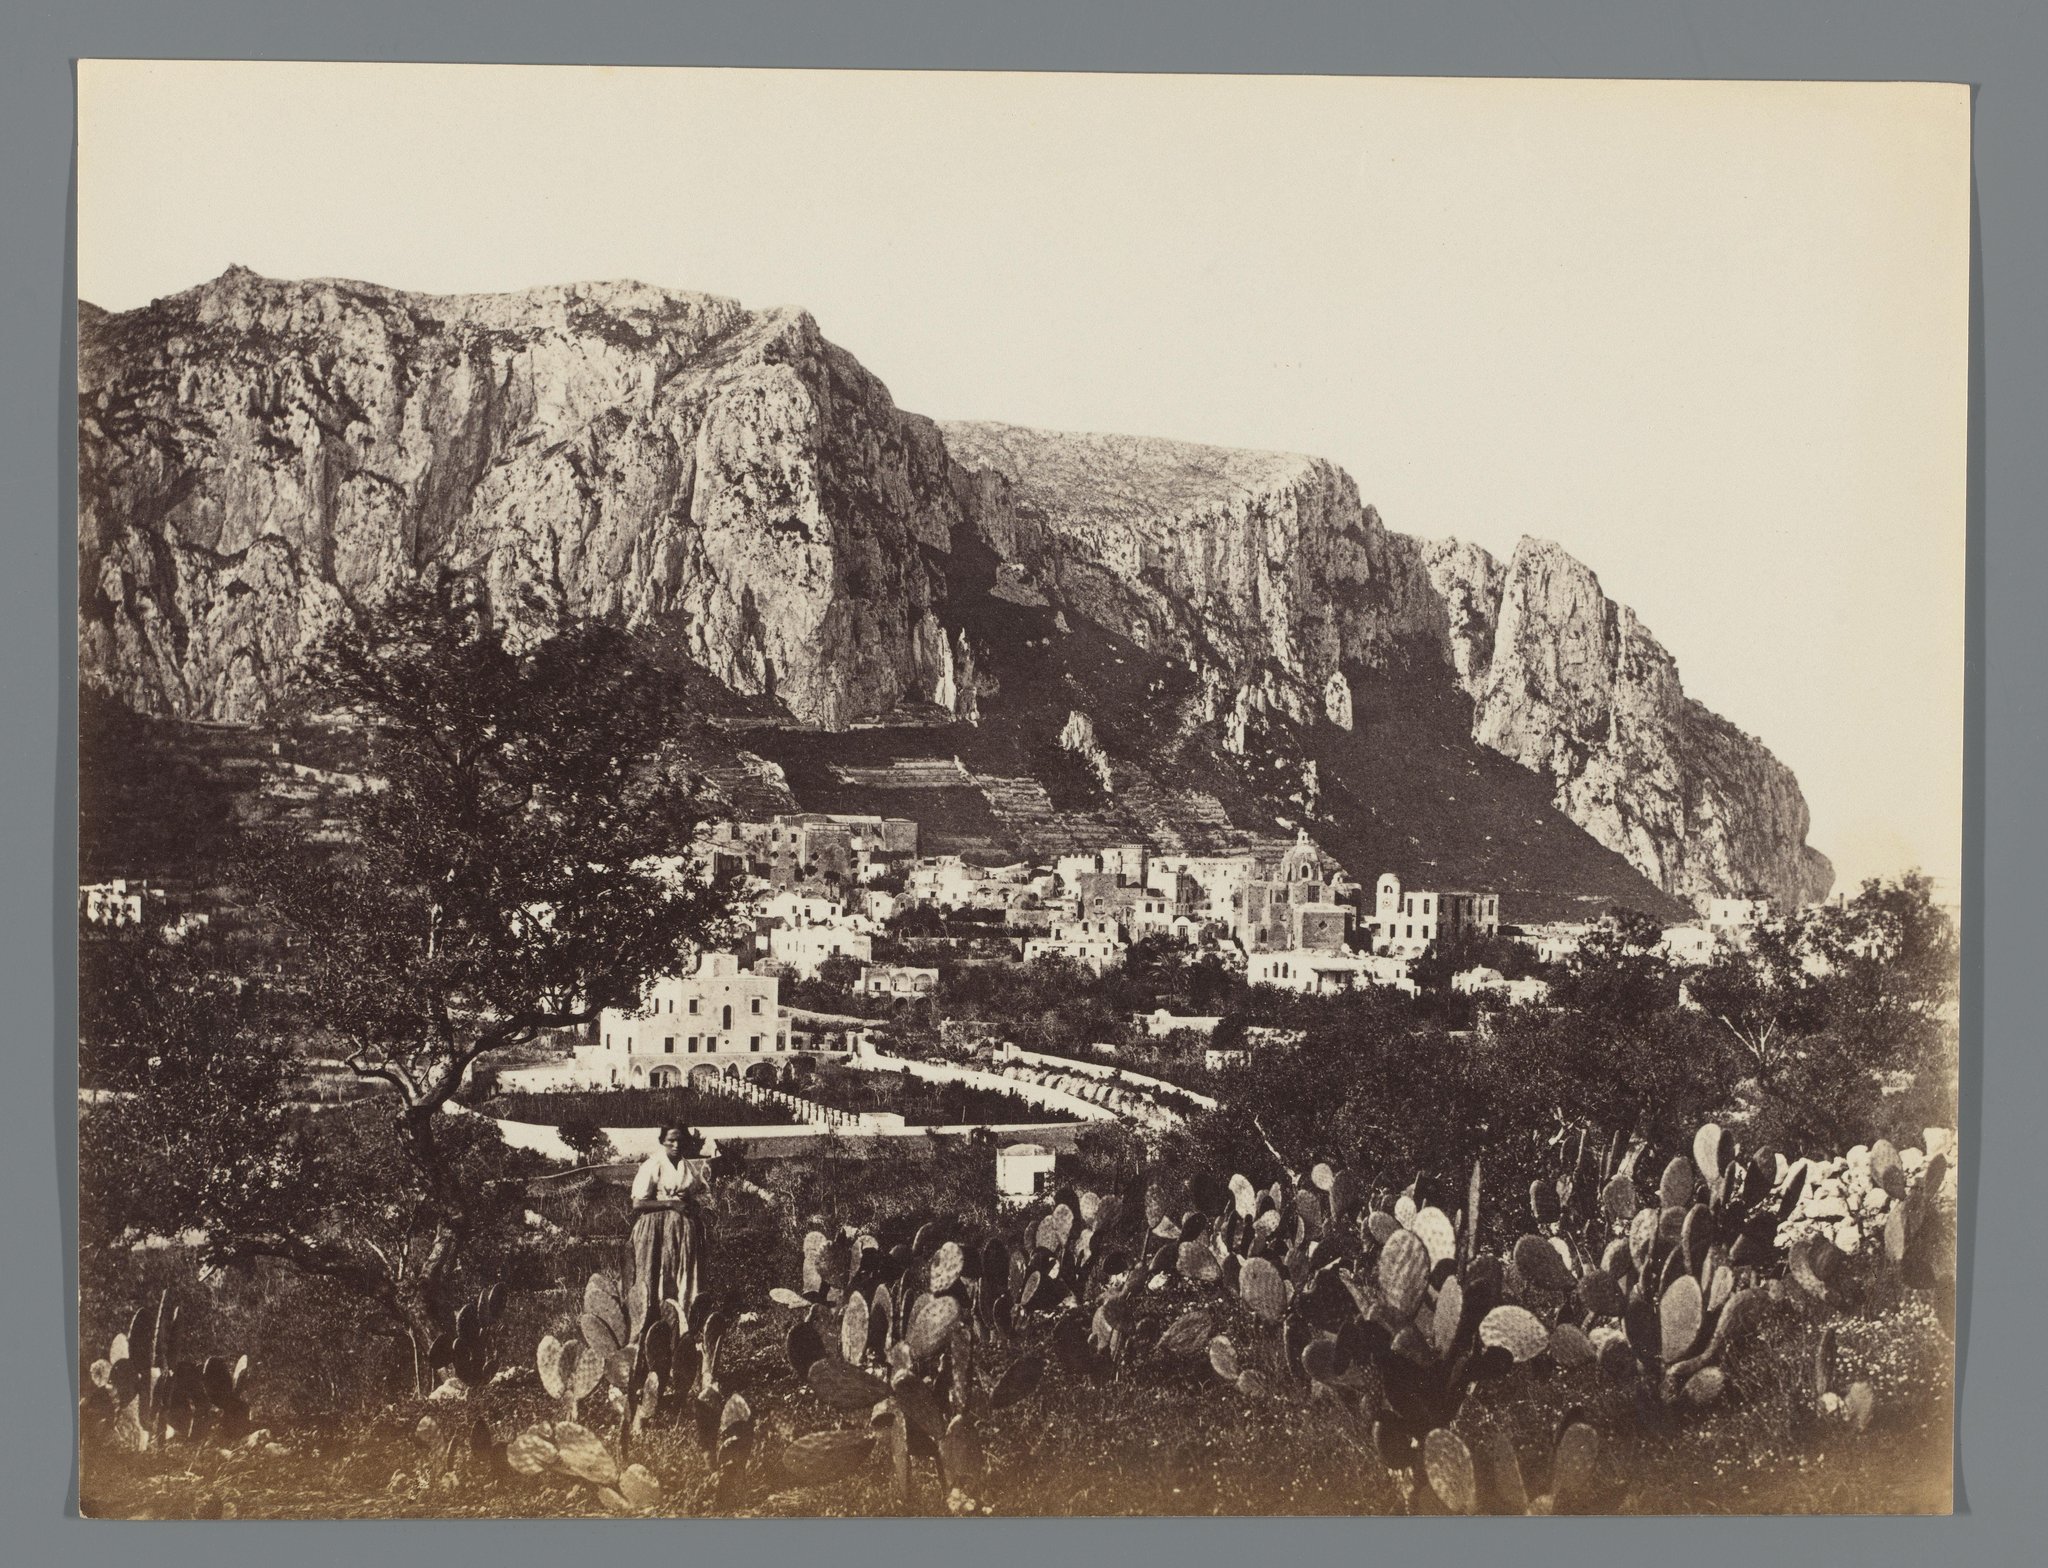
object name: photograph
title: Gezicht op een dorp, mogelijk op Capri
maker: Anonymous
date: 1851-1900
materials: paper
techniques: albumen print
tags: plants and herbs: cactus, prospect of city, town panorama, silhouette of city, mountains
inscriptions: collector's mark: ‘VOSMAER’